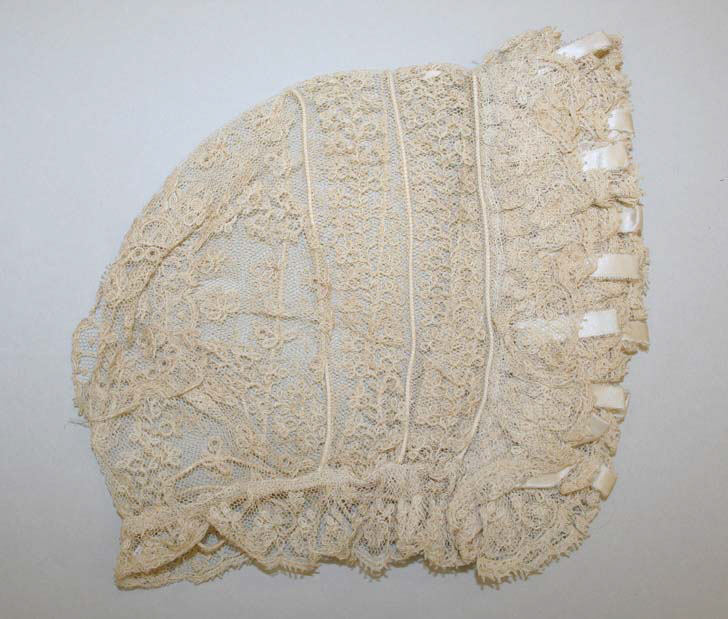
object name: cap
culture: british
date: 1801-1900